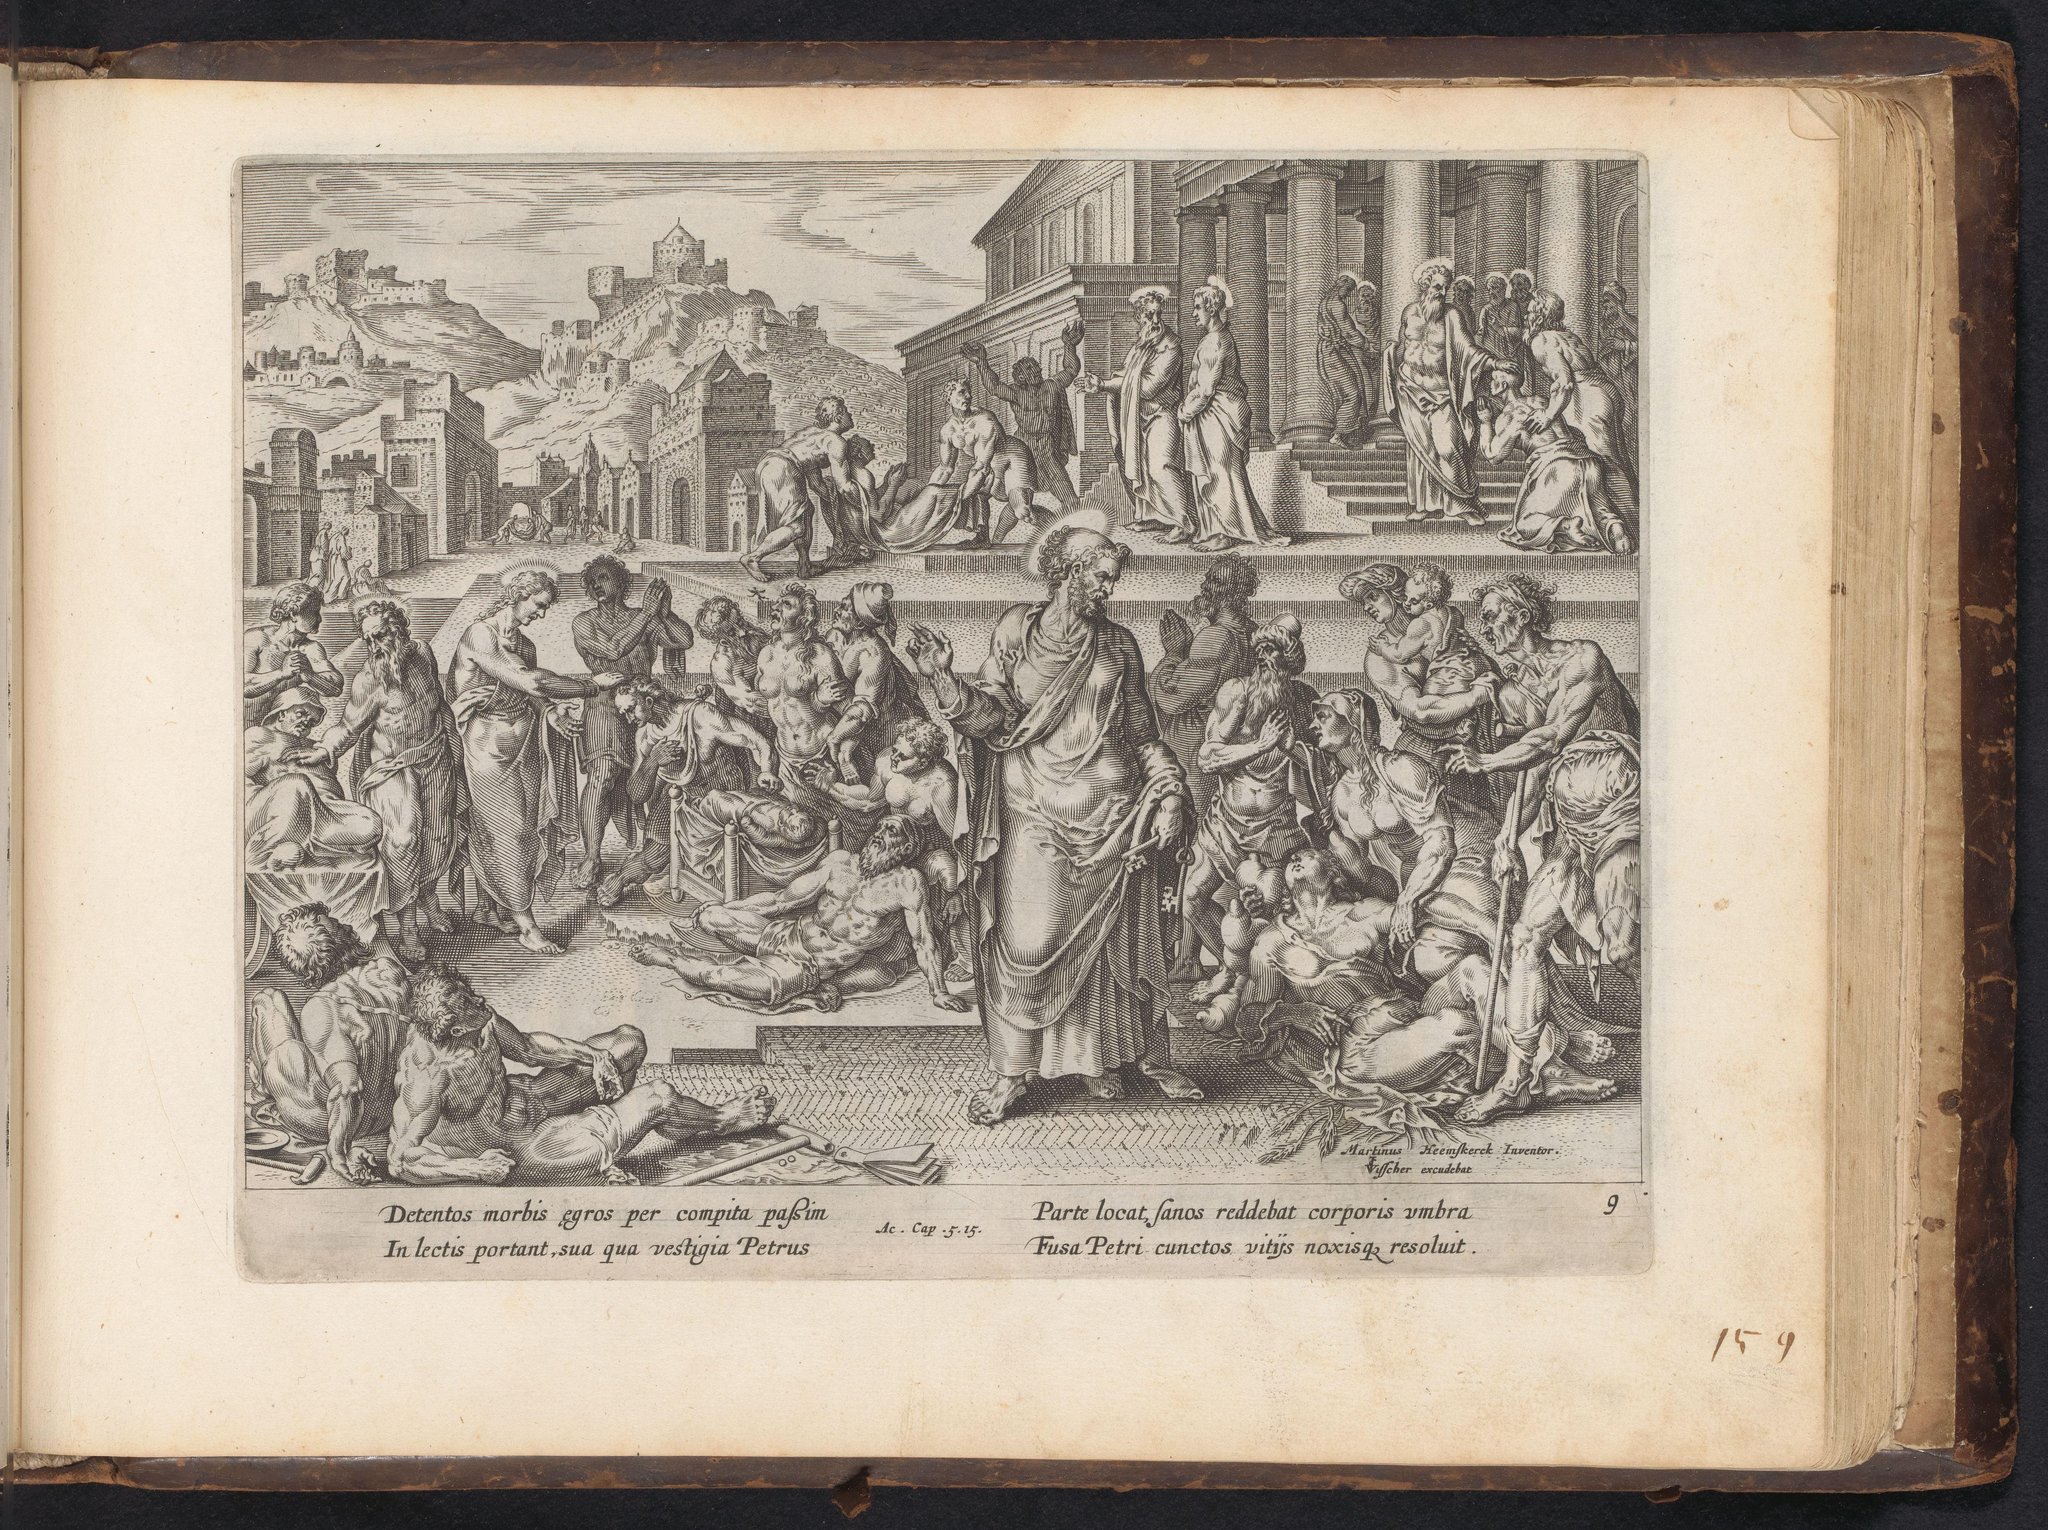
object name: print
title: Petrus geneest zieken met zijn schaduw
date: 1643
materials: paper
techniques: engraving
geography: amsterdam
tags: sick people brought into the streets, so that peter's shadow might fall on them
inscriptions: number: ‘159’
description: Centraal in de voorgrond de apostel Petrus. Rondom hem allemaal zieken en bezetenen. Zij hopen dat Petrus' schaduw op hen zal vallen en hen zal genezen. Samen met Petrus genezen de andere apostelen de zieken en drijven zij geesten uit. Onder de voorstelling een verwijzing in het Latijn naar de Bijbeltekst in Hand. 5:15. Deze prent maakt deel uit van een album.